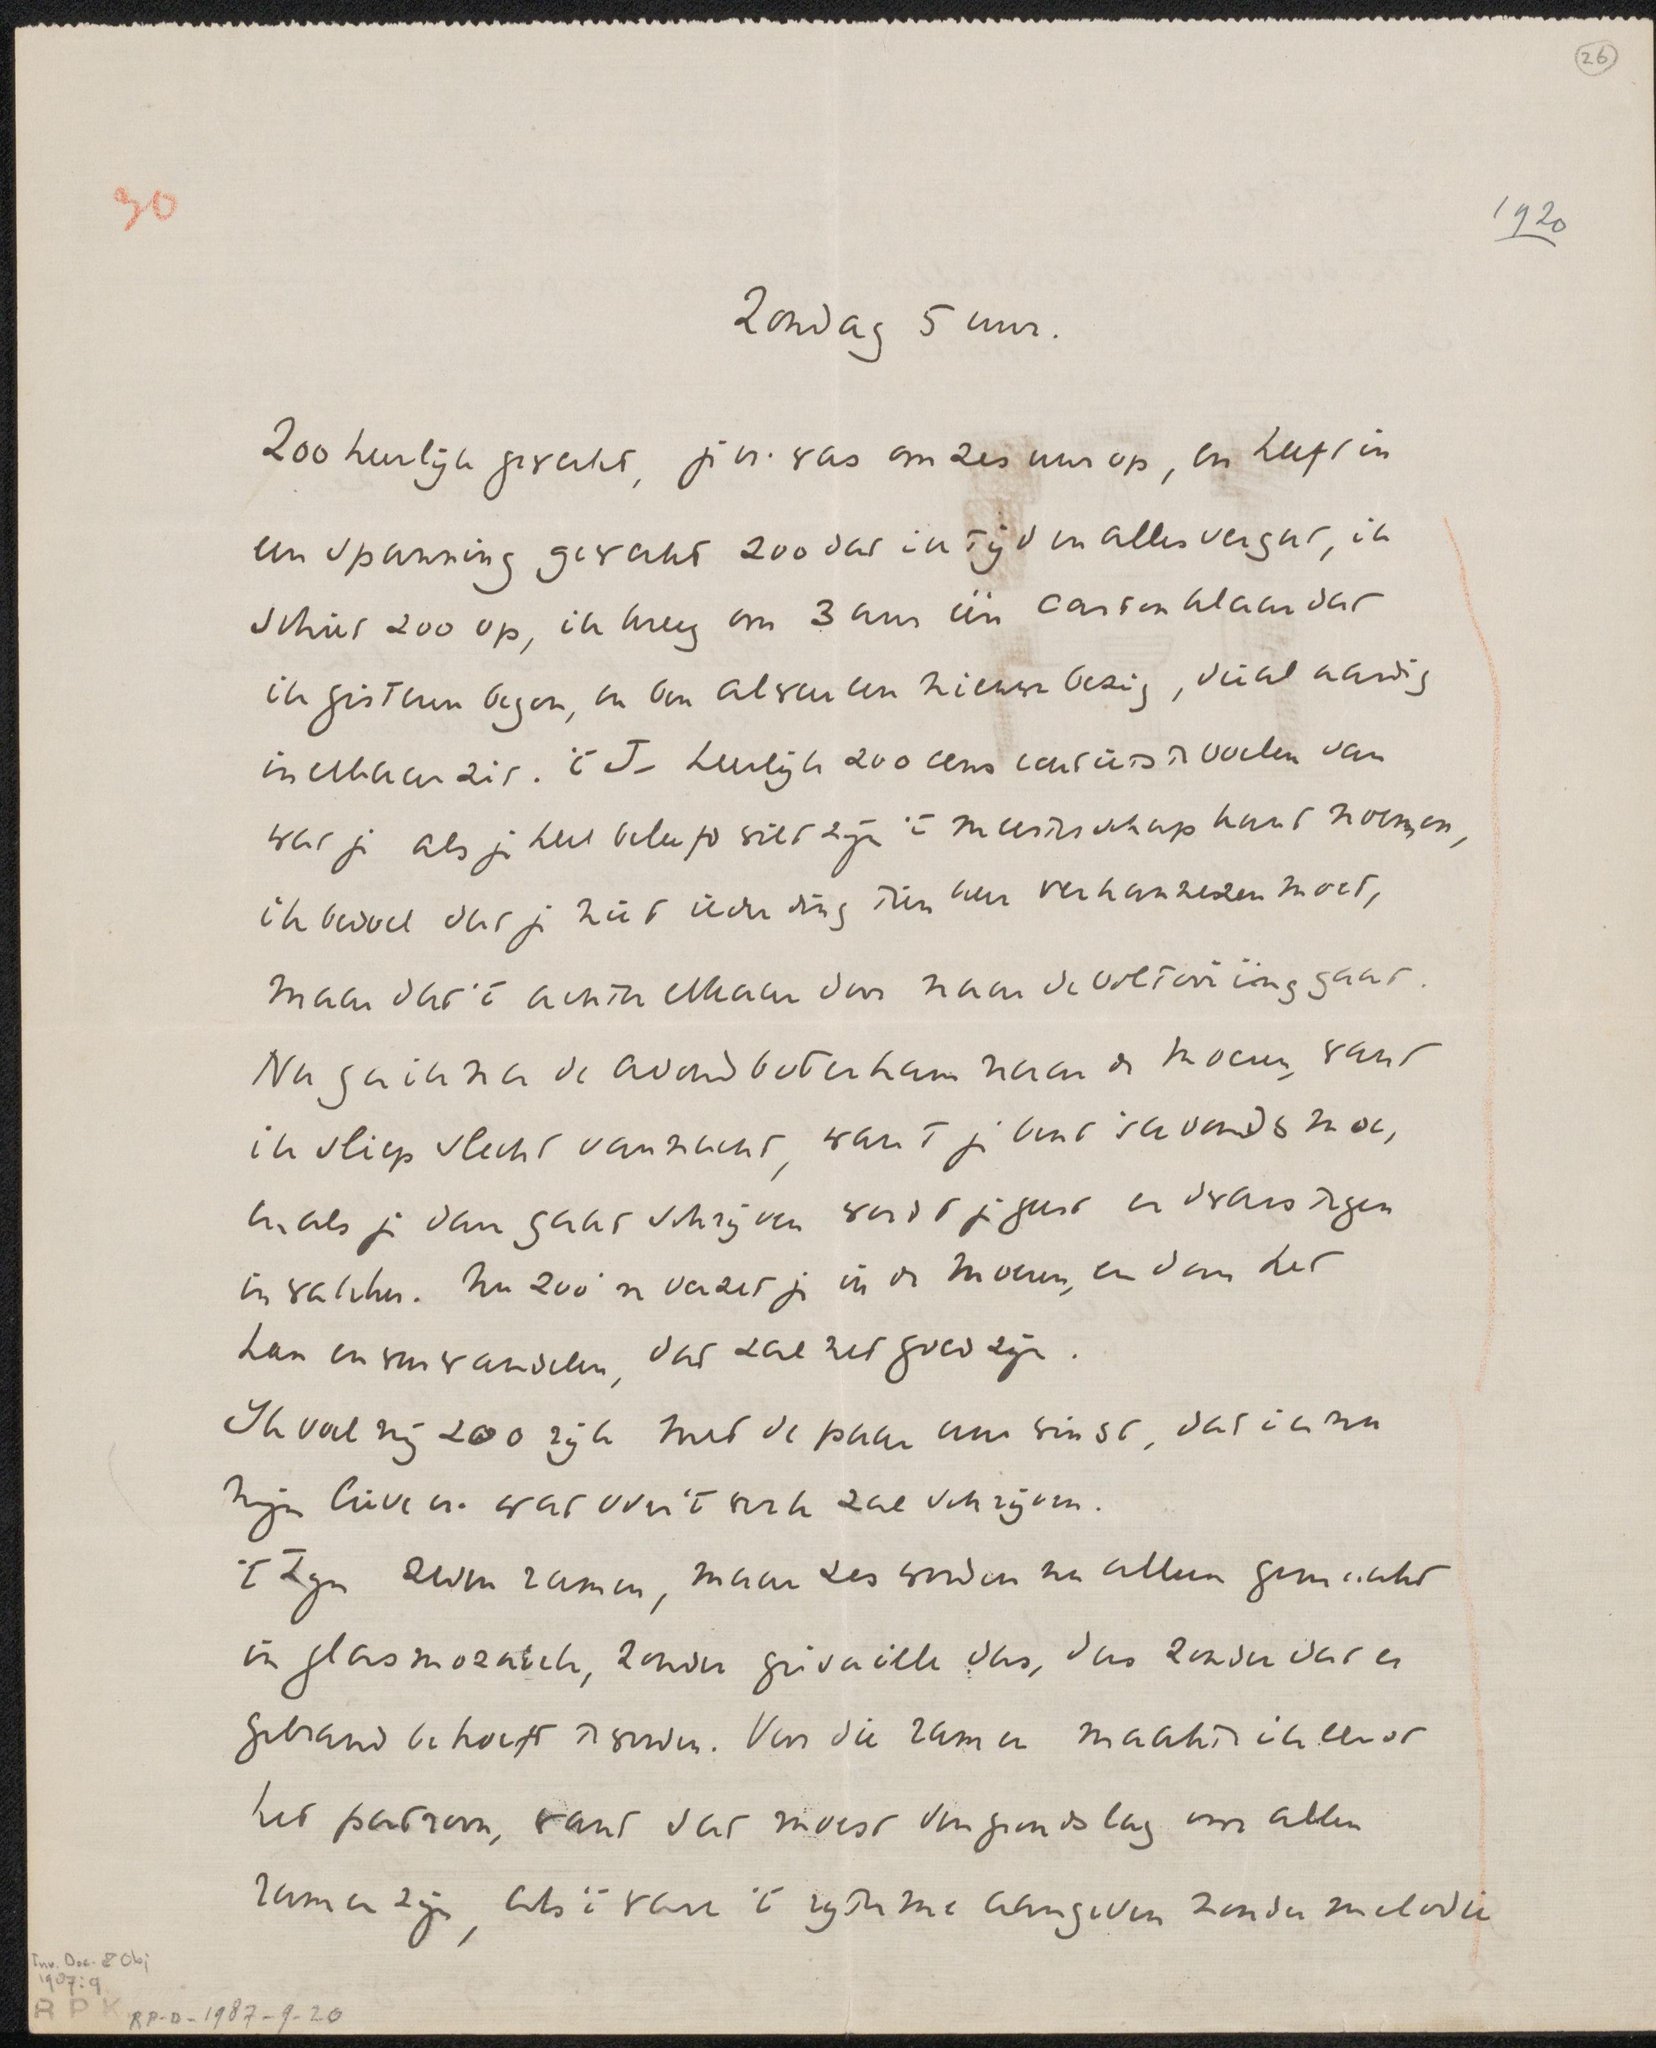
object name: letter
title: Brief aan Ina van Eibergen Santhagens-Waller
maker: richard nicolaüs roland holst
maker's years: 1868-1938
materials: ink, paper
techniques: pen, writing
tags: willem bogtman, drawing, applied arts, arts and crafts; industrial design, historical persons (portraits and scenes from the life), delft, haarlem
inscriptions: collector's mark: ‘RPK’